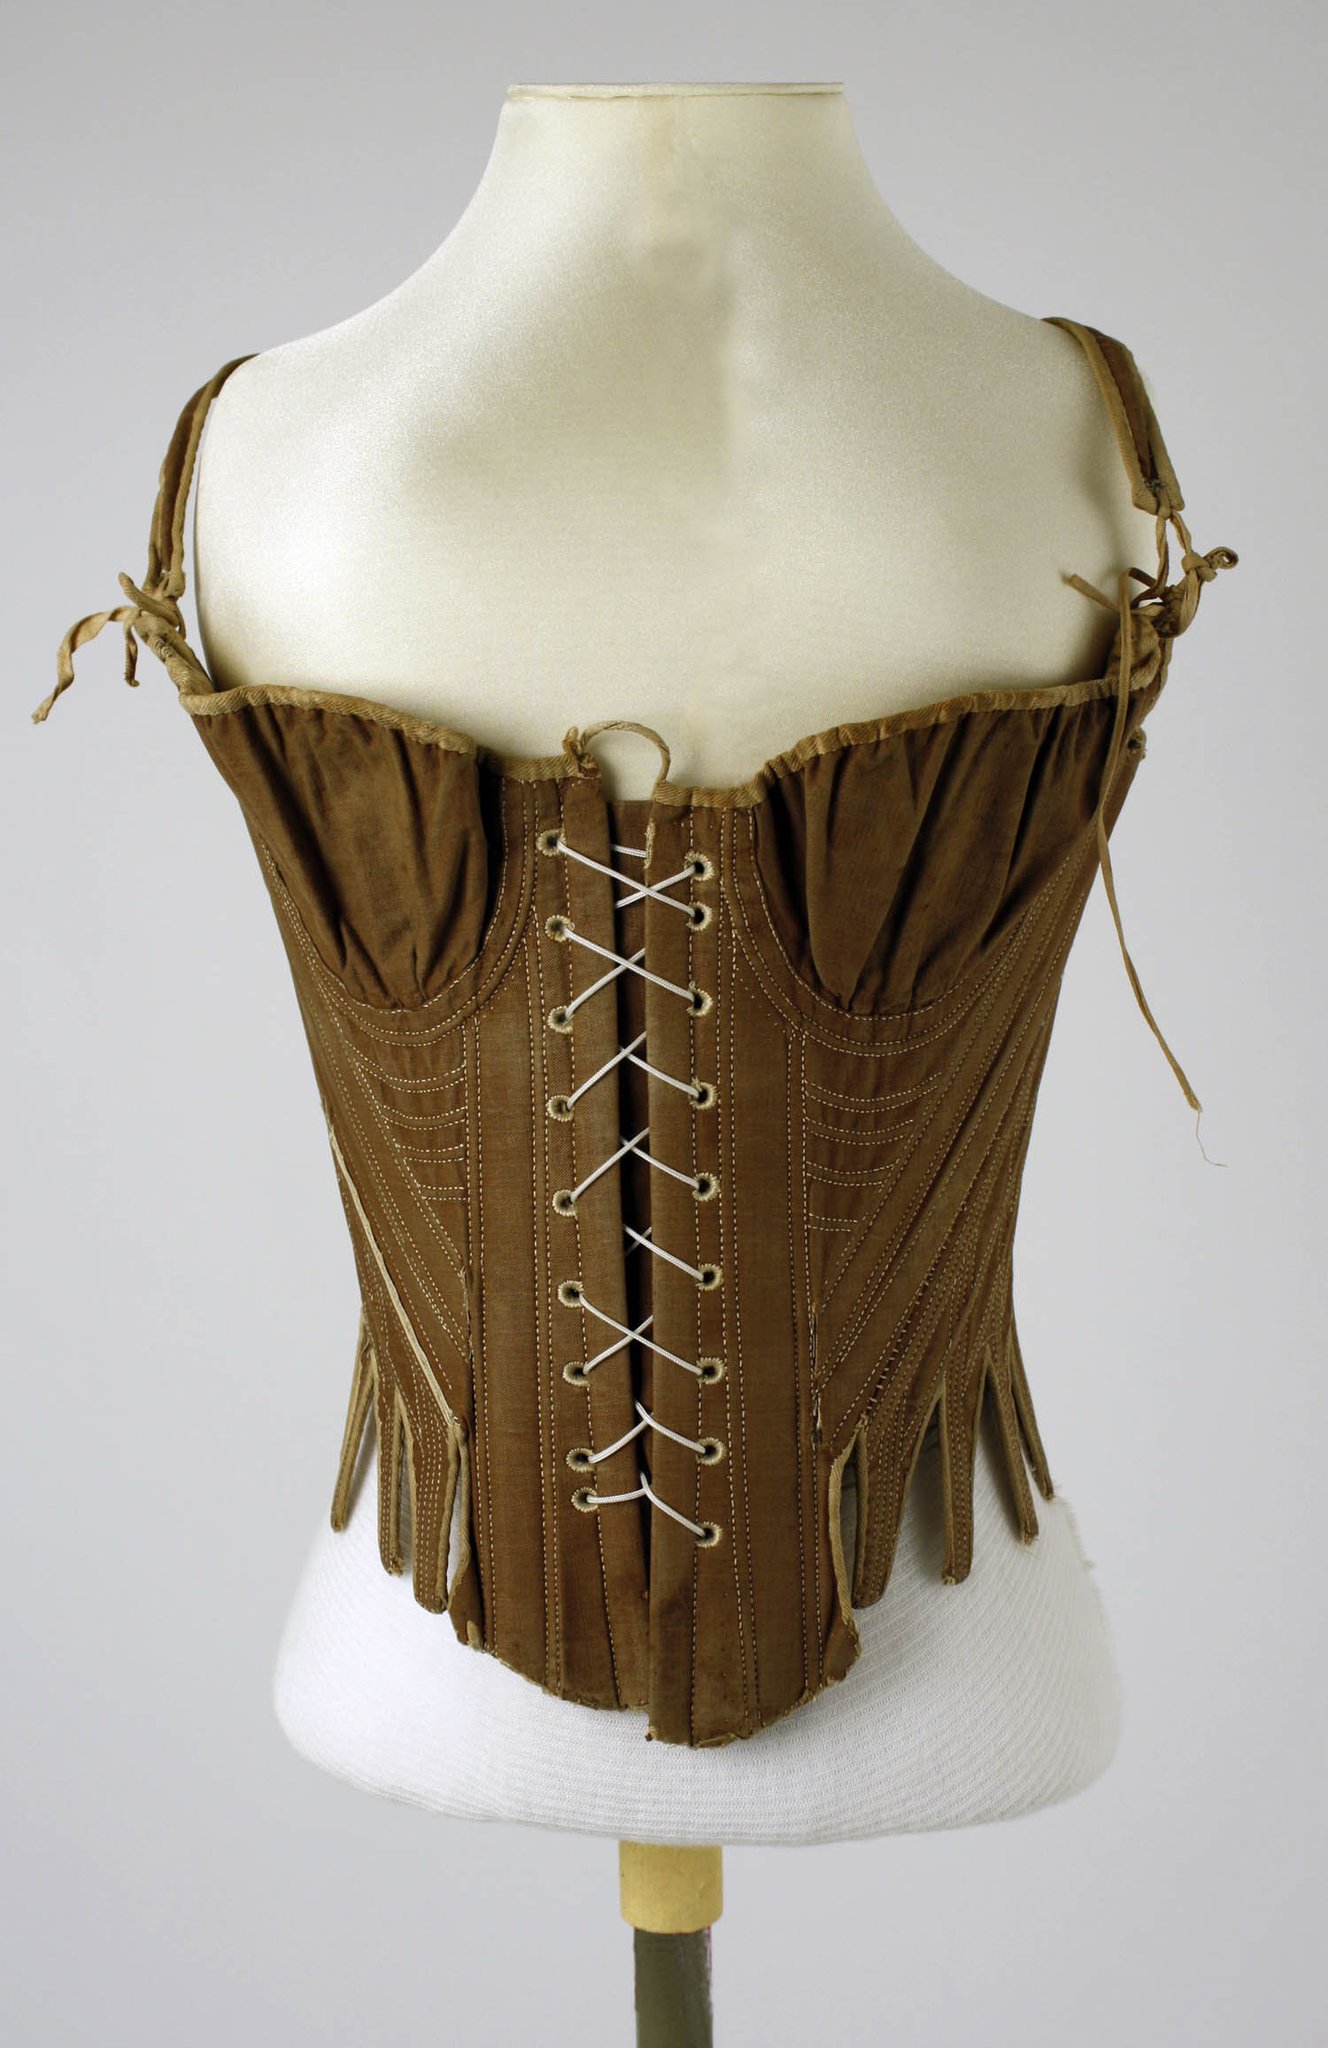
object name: corset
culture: american or european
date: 1800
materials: cotton, silk